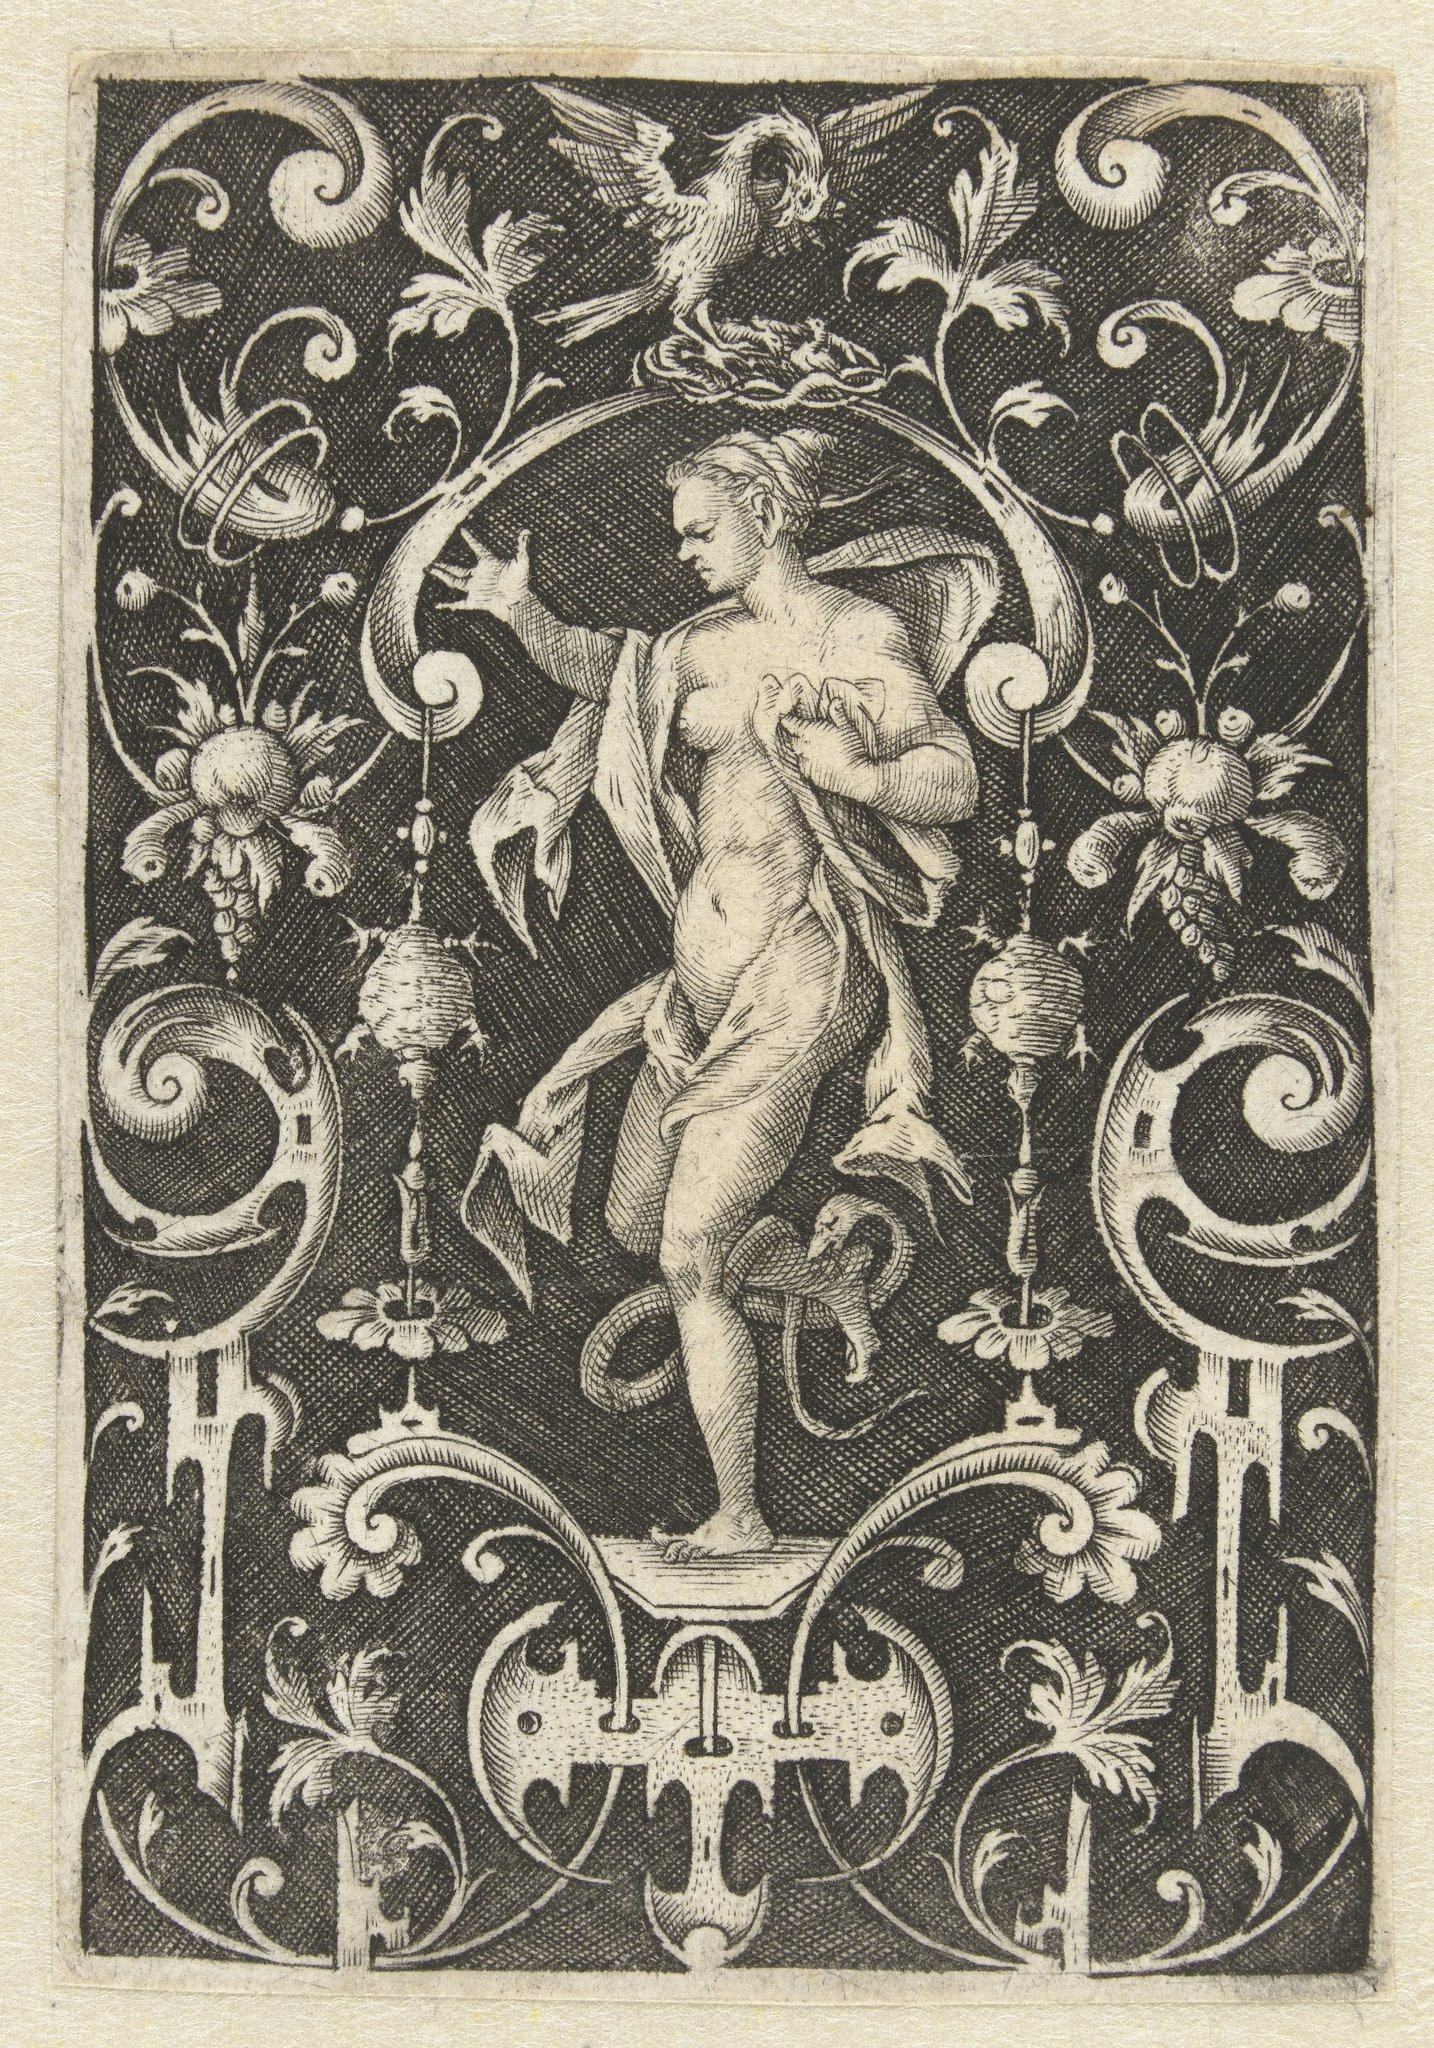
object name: print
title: Personificaties van de vijf zintuigen, omringd door grotesken met dieren en vruchten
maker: Anonymous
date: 1563-1633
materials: paper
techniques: engraving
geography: germany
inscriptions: collector's mark: Lugt 1379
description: Een vrouw, die door een slang in haar enkel gebeten wordt, tussen twee schildpadden. Gearceerde achtergrond. Uit serie bestaande uit een titelblad en 5 bladen met vlakdecoraties.